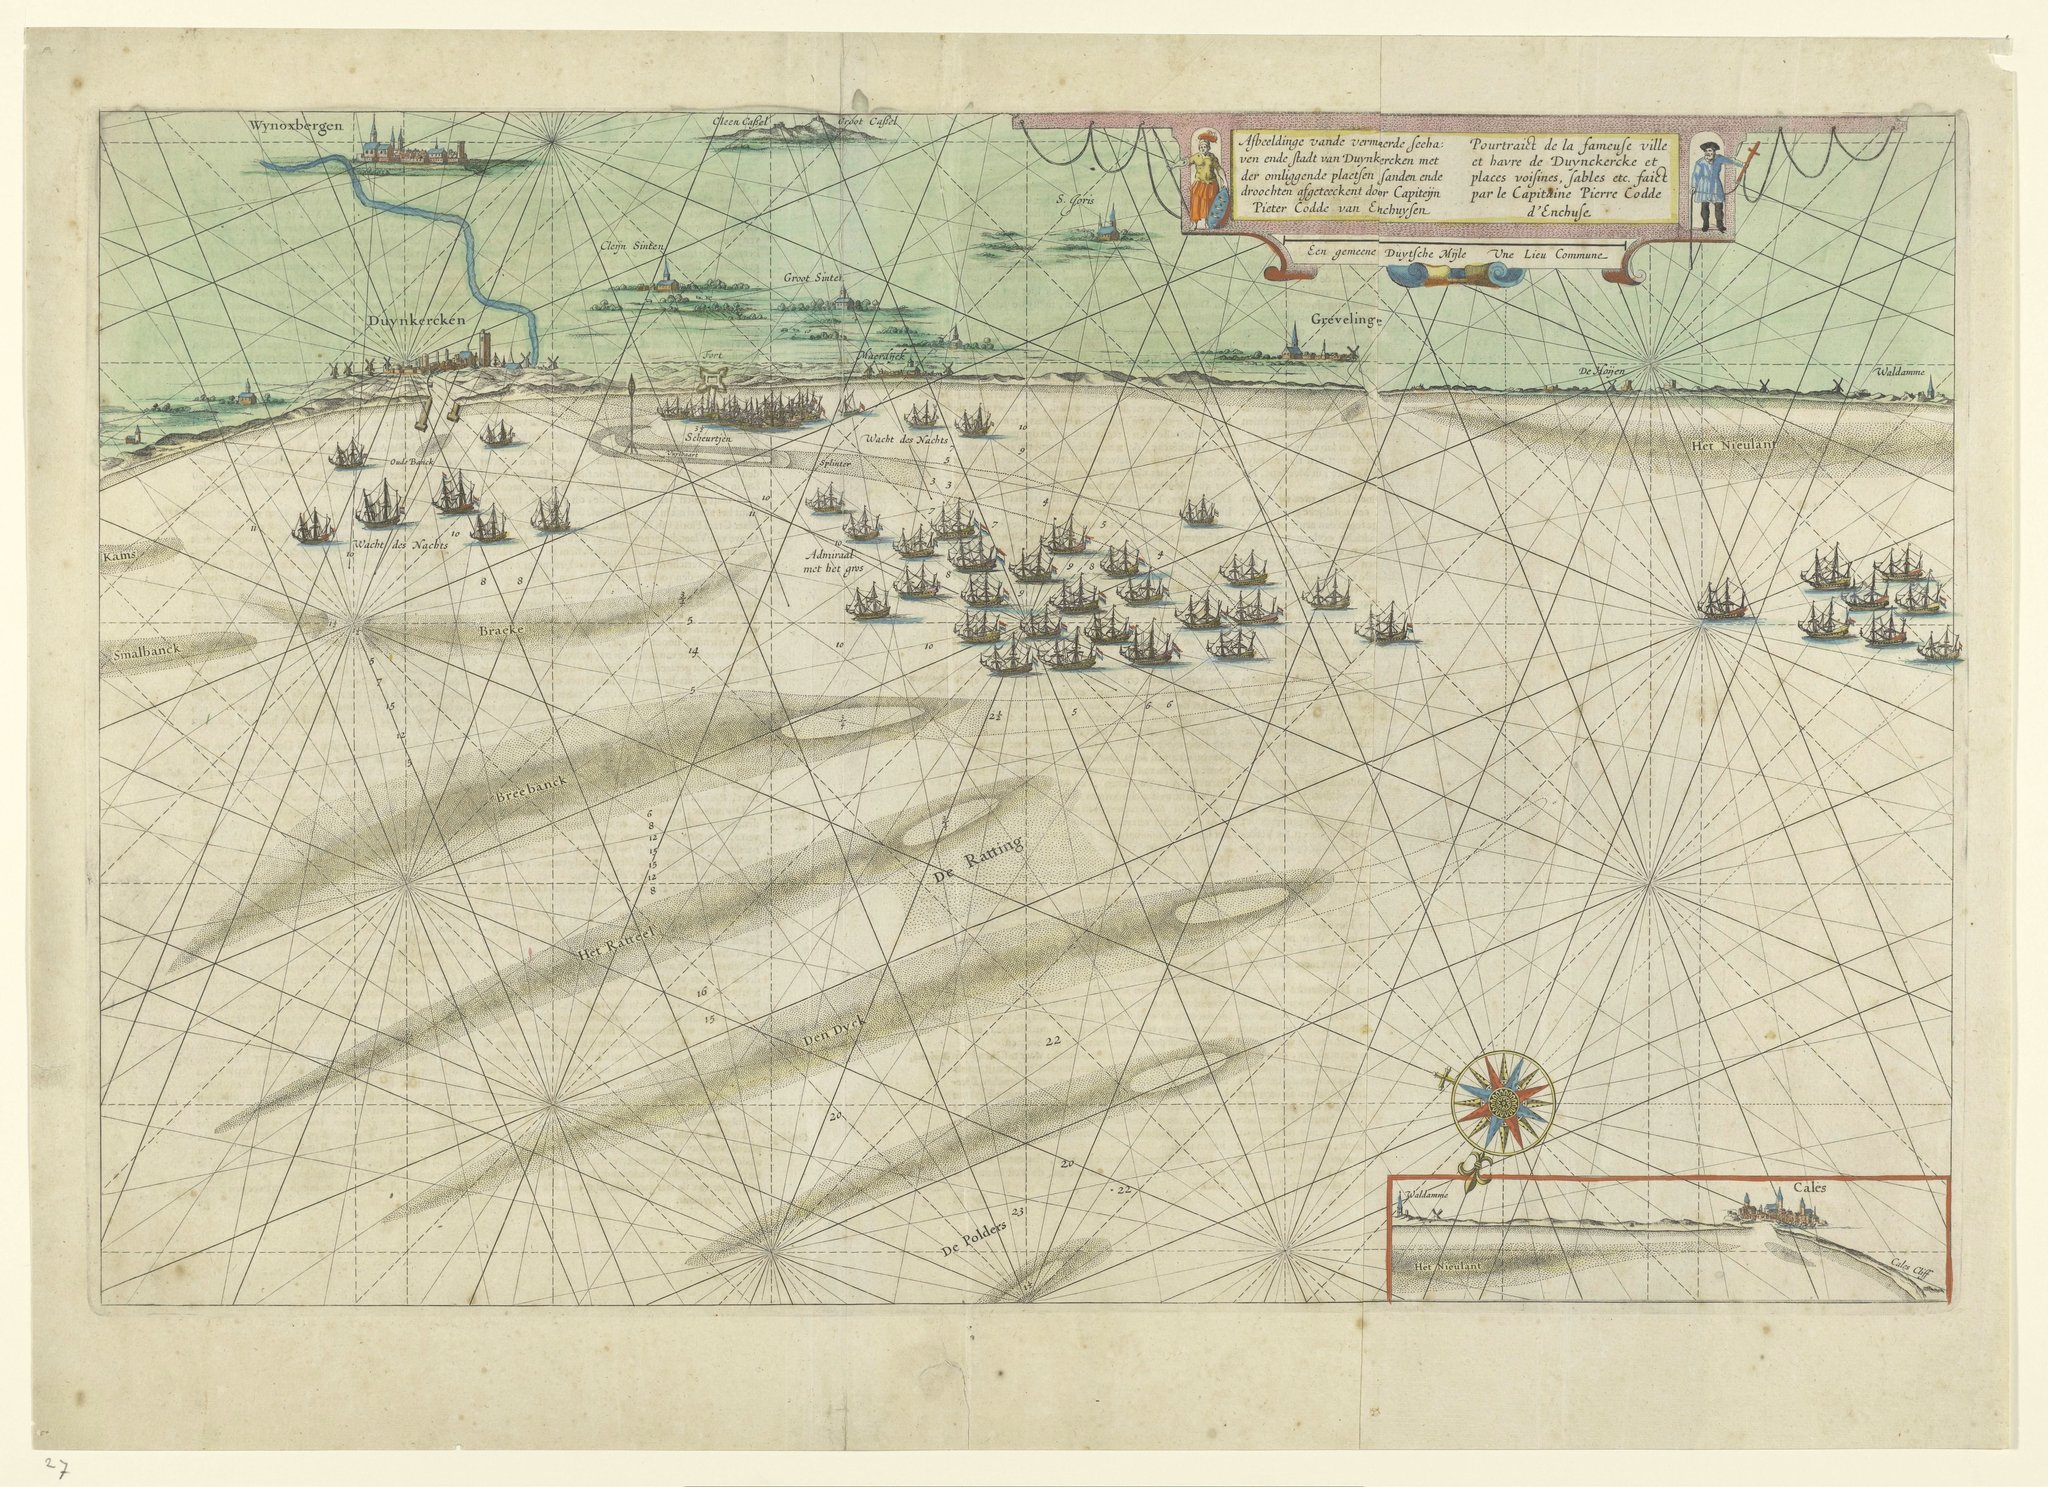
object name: map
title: Afbeeldinge vande vermaerde seehaven ende stadt van Duynkercken met der omliggende plaetsen sanden ende droochten / Pourtraict de la fameuse ville et havre de Duynckercke et places voisines, sables ...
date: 1634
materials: paper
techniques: engraving, etching, hand coloring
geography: amsterdam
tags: marine charts, maps of separate countries or regions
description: Kaart van de zandbanken voor de Vlaamse kust tussen Duinkerken en Grevelingen. In de zee zijn de zandbanken aangegeven en verschillende vloten (Wacht des Nachts, Admiraal met het gros). Rechtsonder een inzet met een kaartje van de kust bij Calais. De cartouche met de titels is geflankeerd door twee allegorische figuren, vlak eronder de schaal in Duitse mijlen. De achterzijde bedrukt met tekst in het Nederlands 'Vlaems-Vlaenderen', p. 27.